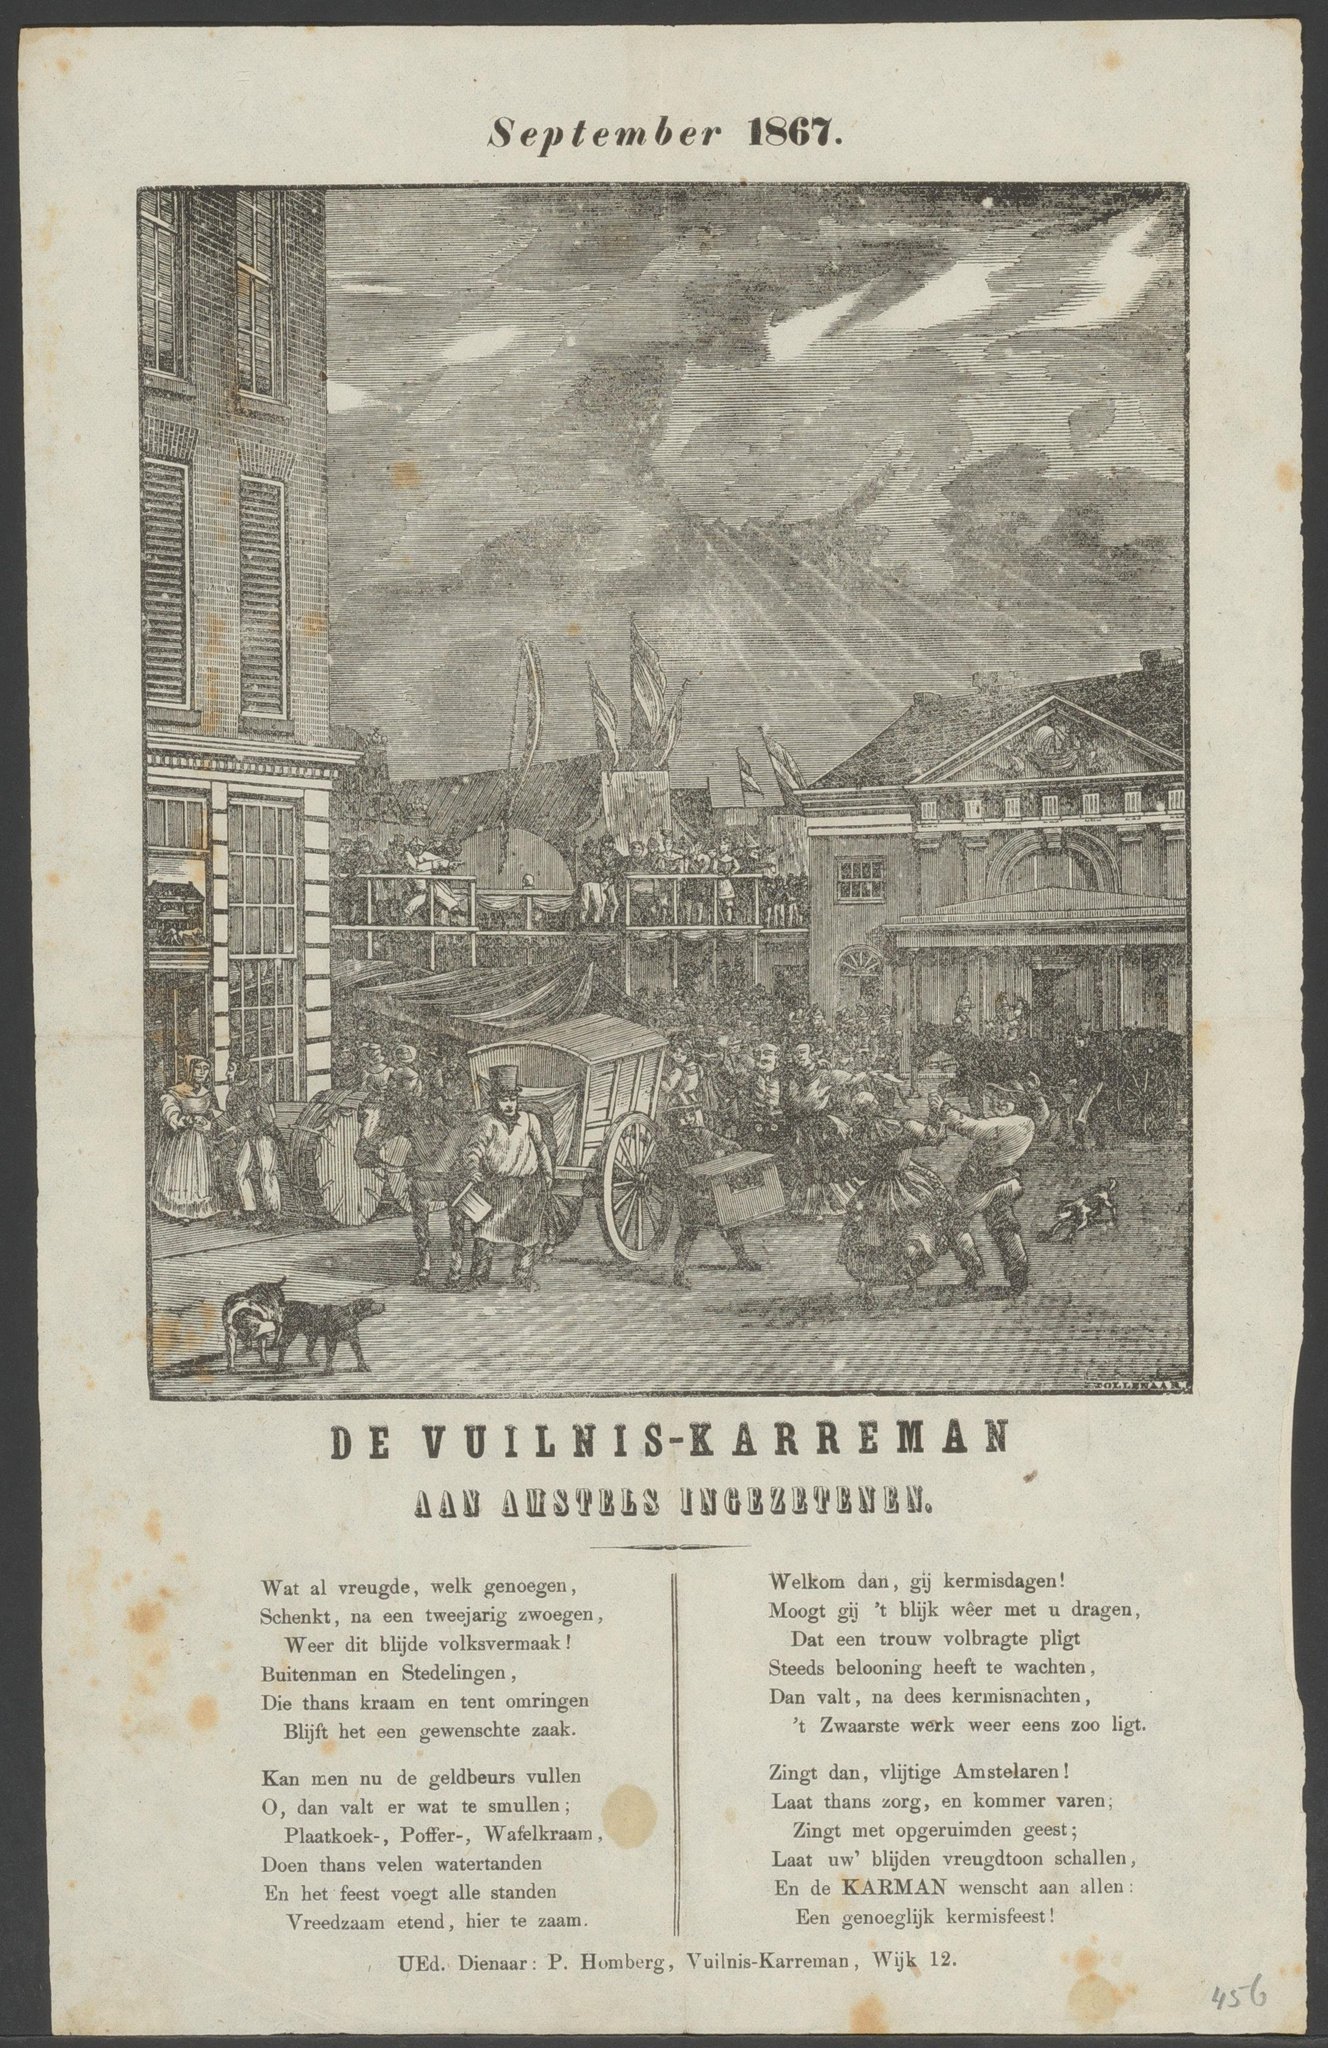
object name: fair print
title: De Vuilnis-Karreman aan Amstels Ingezetenen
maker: dirk wijbrand tollenaar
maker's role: print maker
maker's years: 1808-1858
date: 1867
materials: paper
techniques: letterpress printing, engraving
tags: street, garbage collection, amsterdam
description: Kermisprent van de Amsterdamse vuilnismannen voor het jaar 1867. Gezicht op de kermis op de Botermarkt met de oude Waag. Op de markt twee vuilniskarren. Met gedicht in twee kolommen. Van de vuilniskarman in de wijk no. 7: P. Landzaad. Onderwerpsrubrieken binnen de Atlas Zeden en Gewoonten: Zeden en gewoonten in engeren zin, Volksleven, Volksbladen, Nieuwjaars- en Kerstwenschen, Amsterdam.